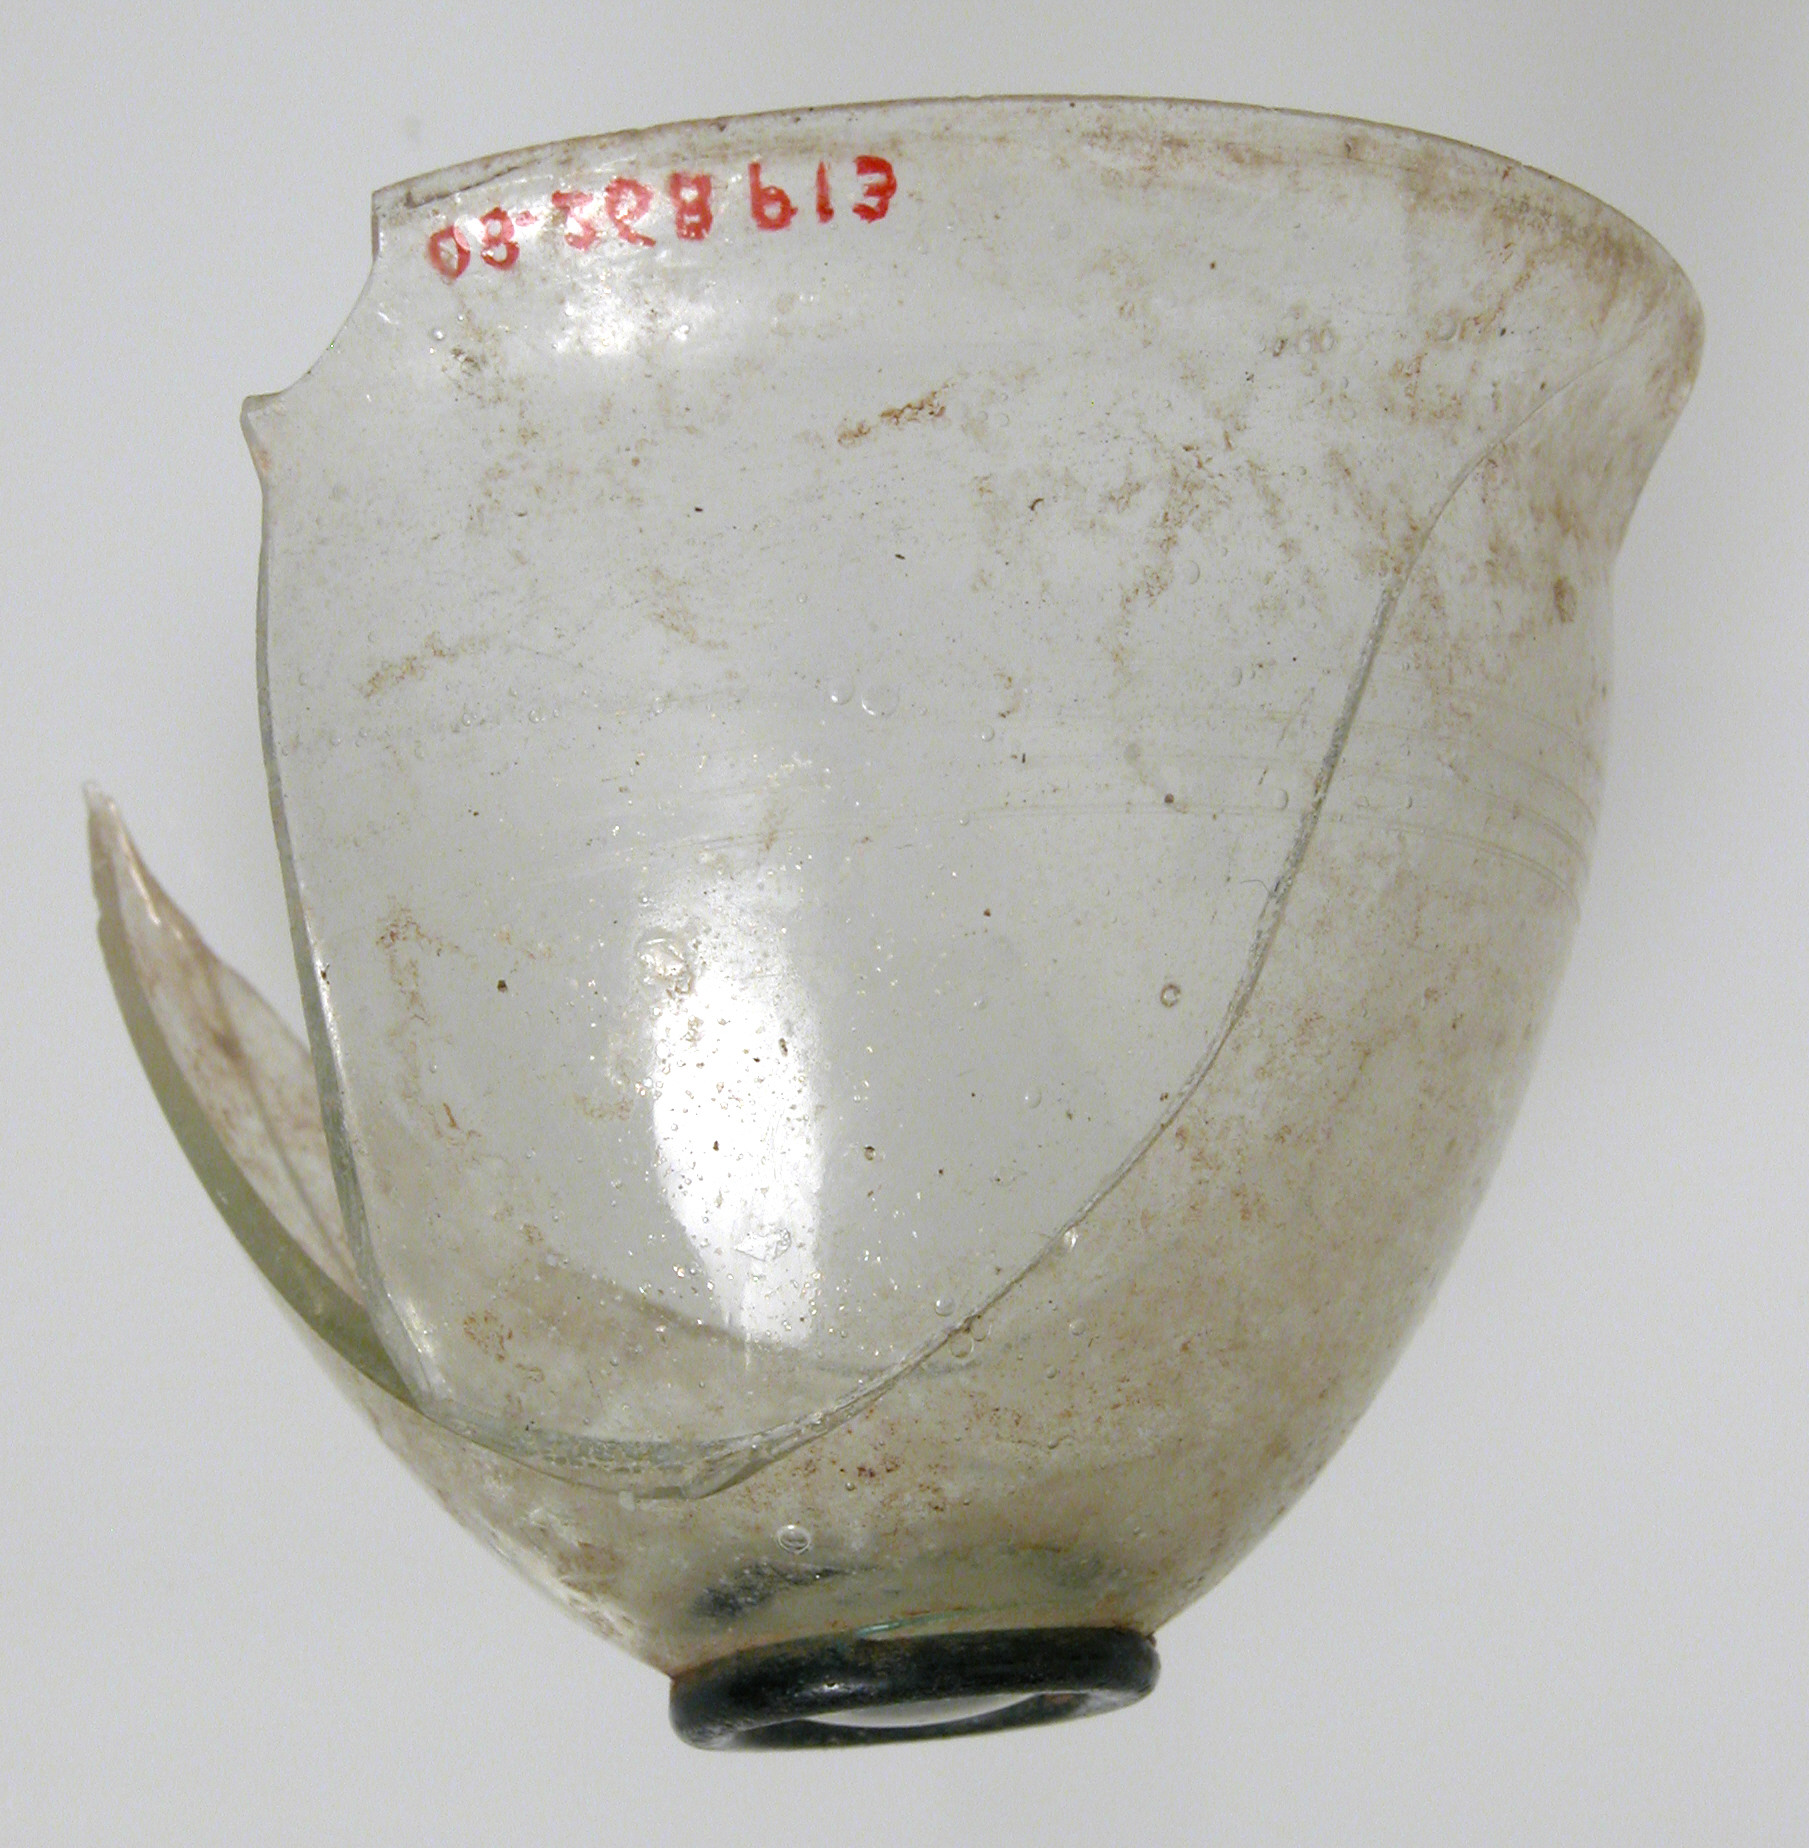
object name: fragment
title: Fragment of Bowl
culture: coptic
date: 301-433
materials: glass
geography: egypt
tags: bowls